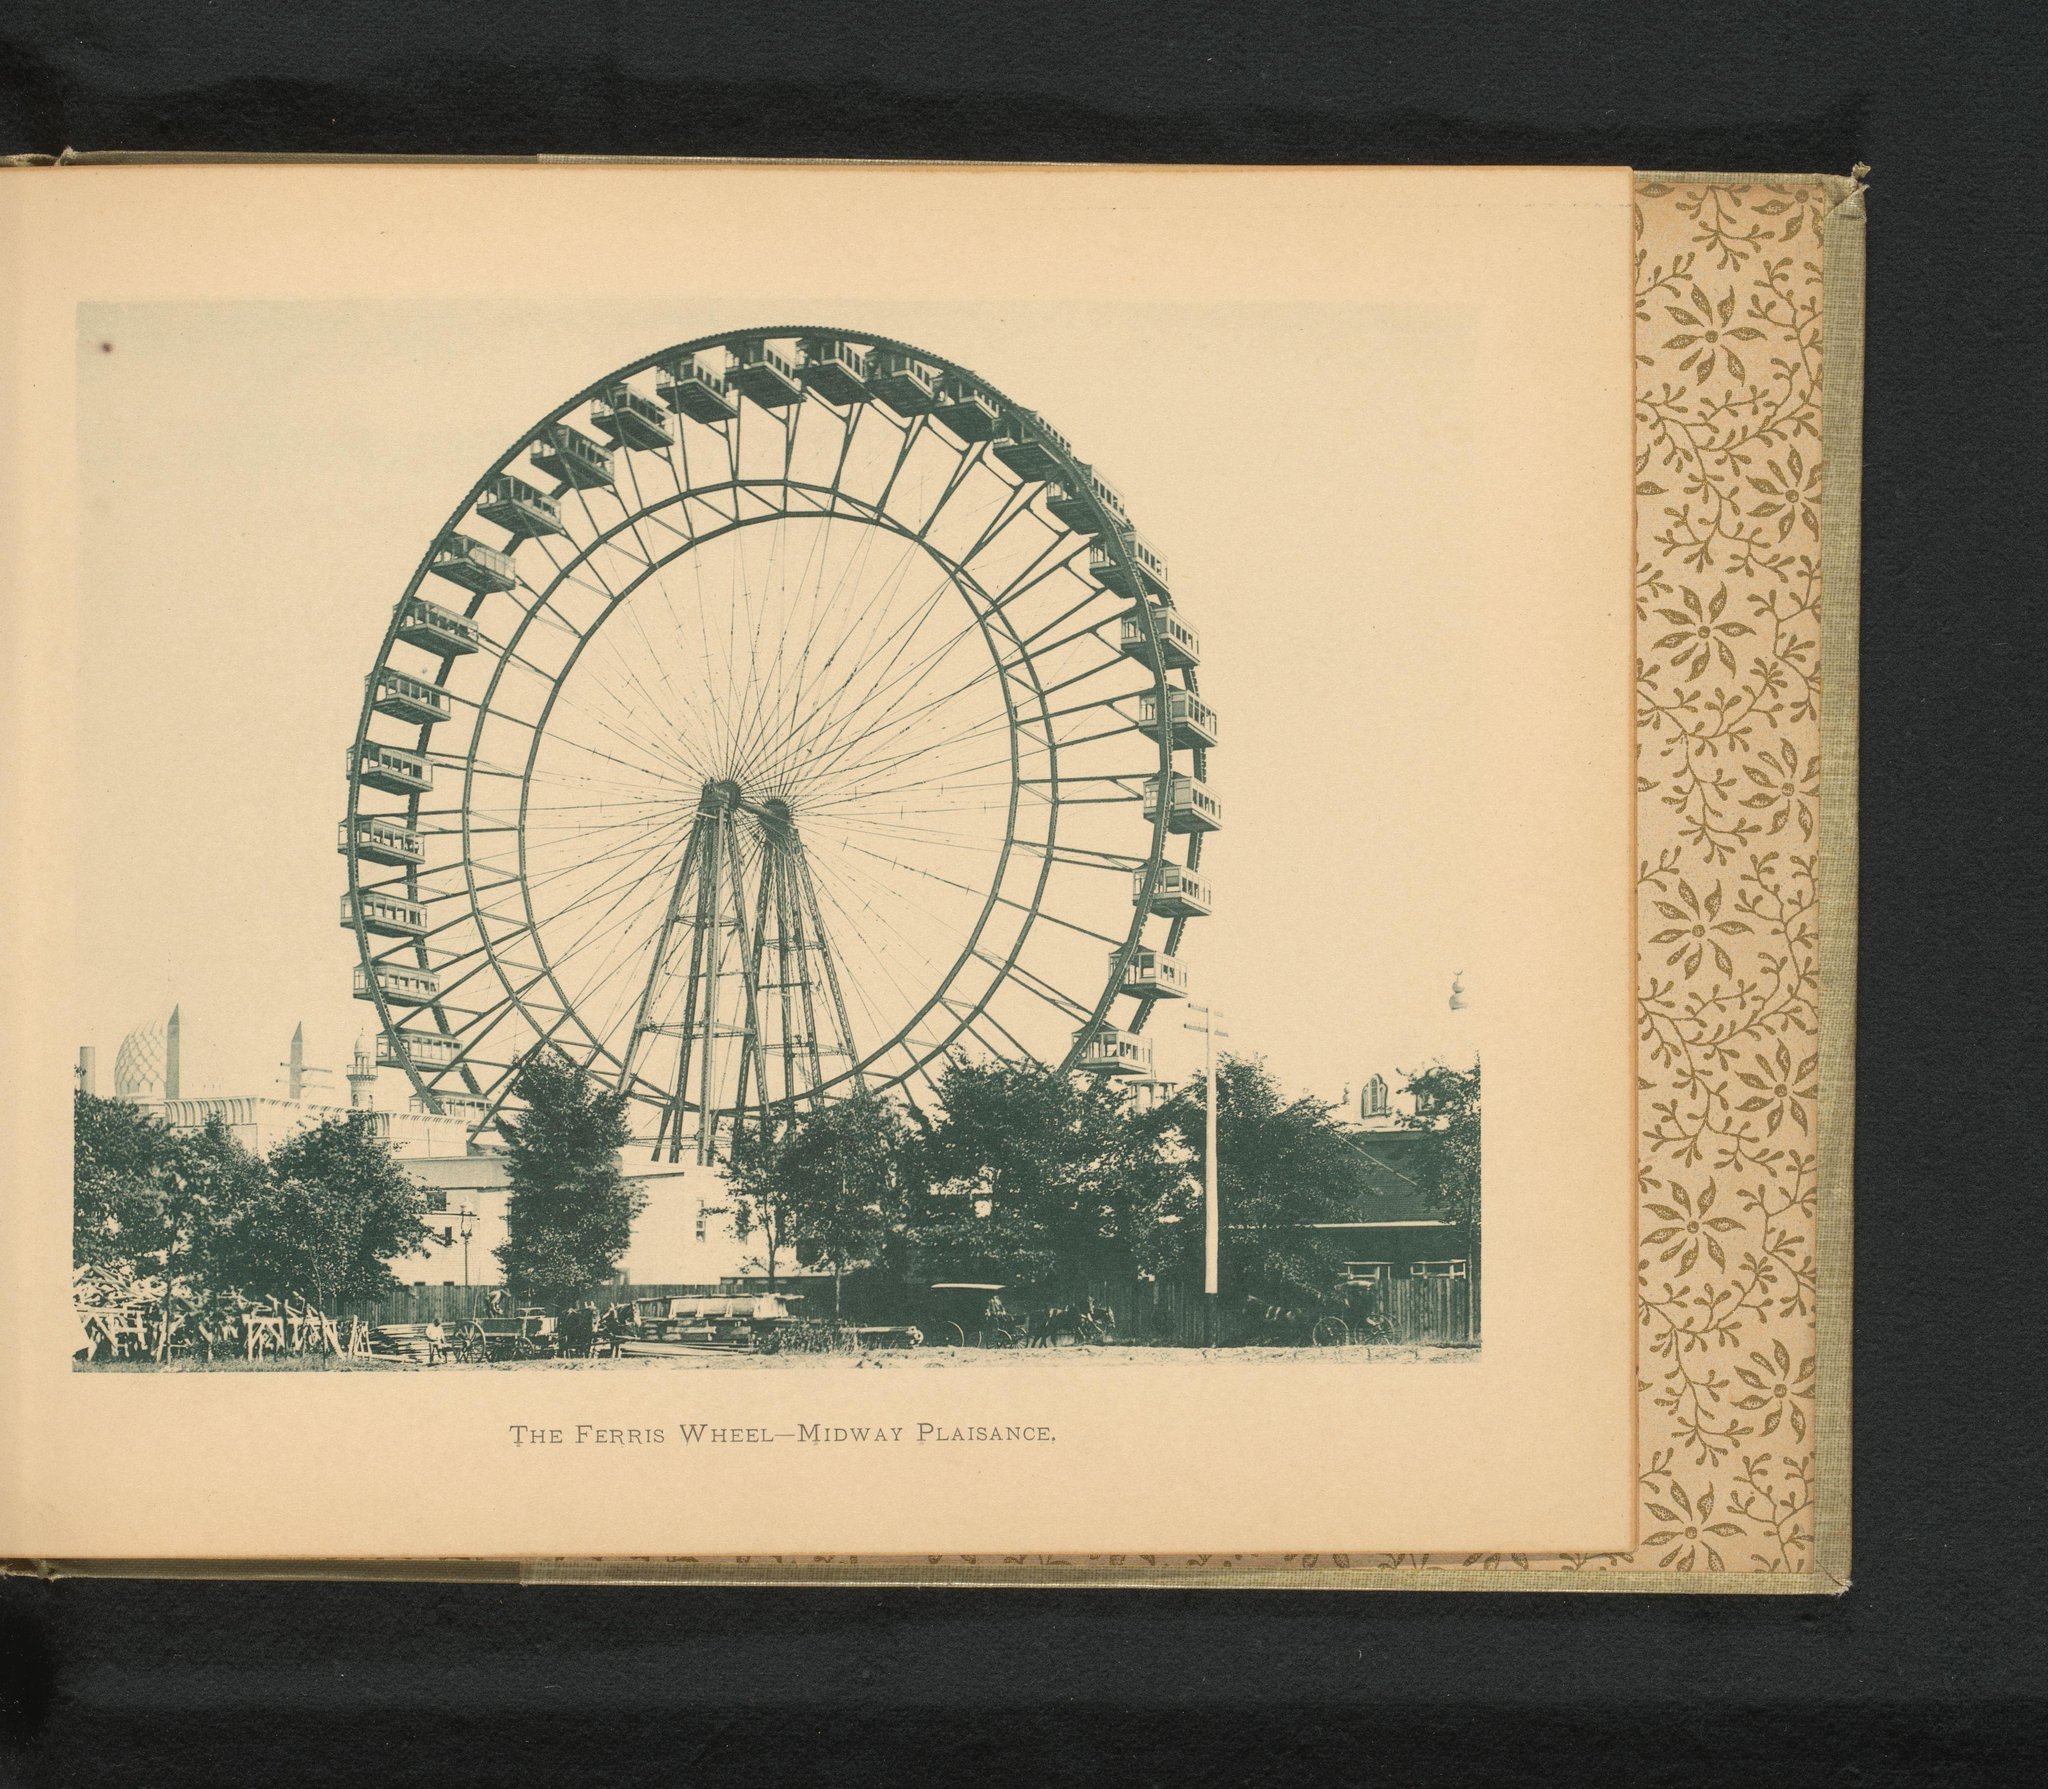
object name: page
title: The Ferris Wheel - Midway Plaisance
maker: Anonymous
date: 1893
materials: paper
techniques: photograph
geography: chicago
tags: world fair, world exhibition, giant wheel, ferris wheel